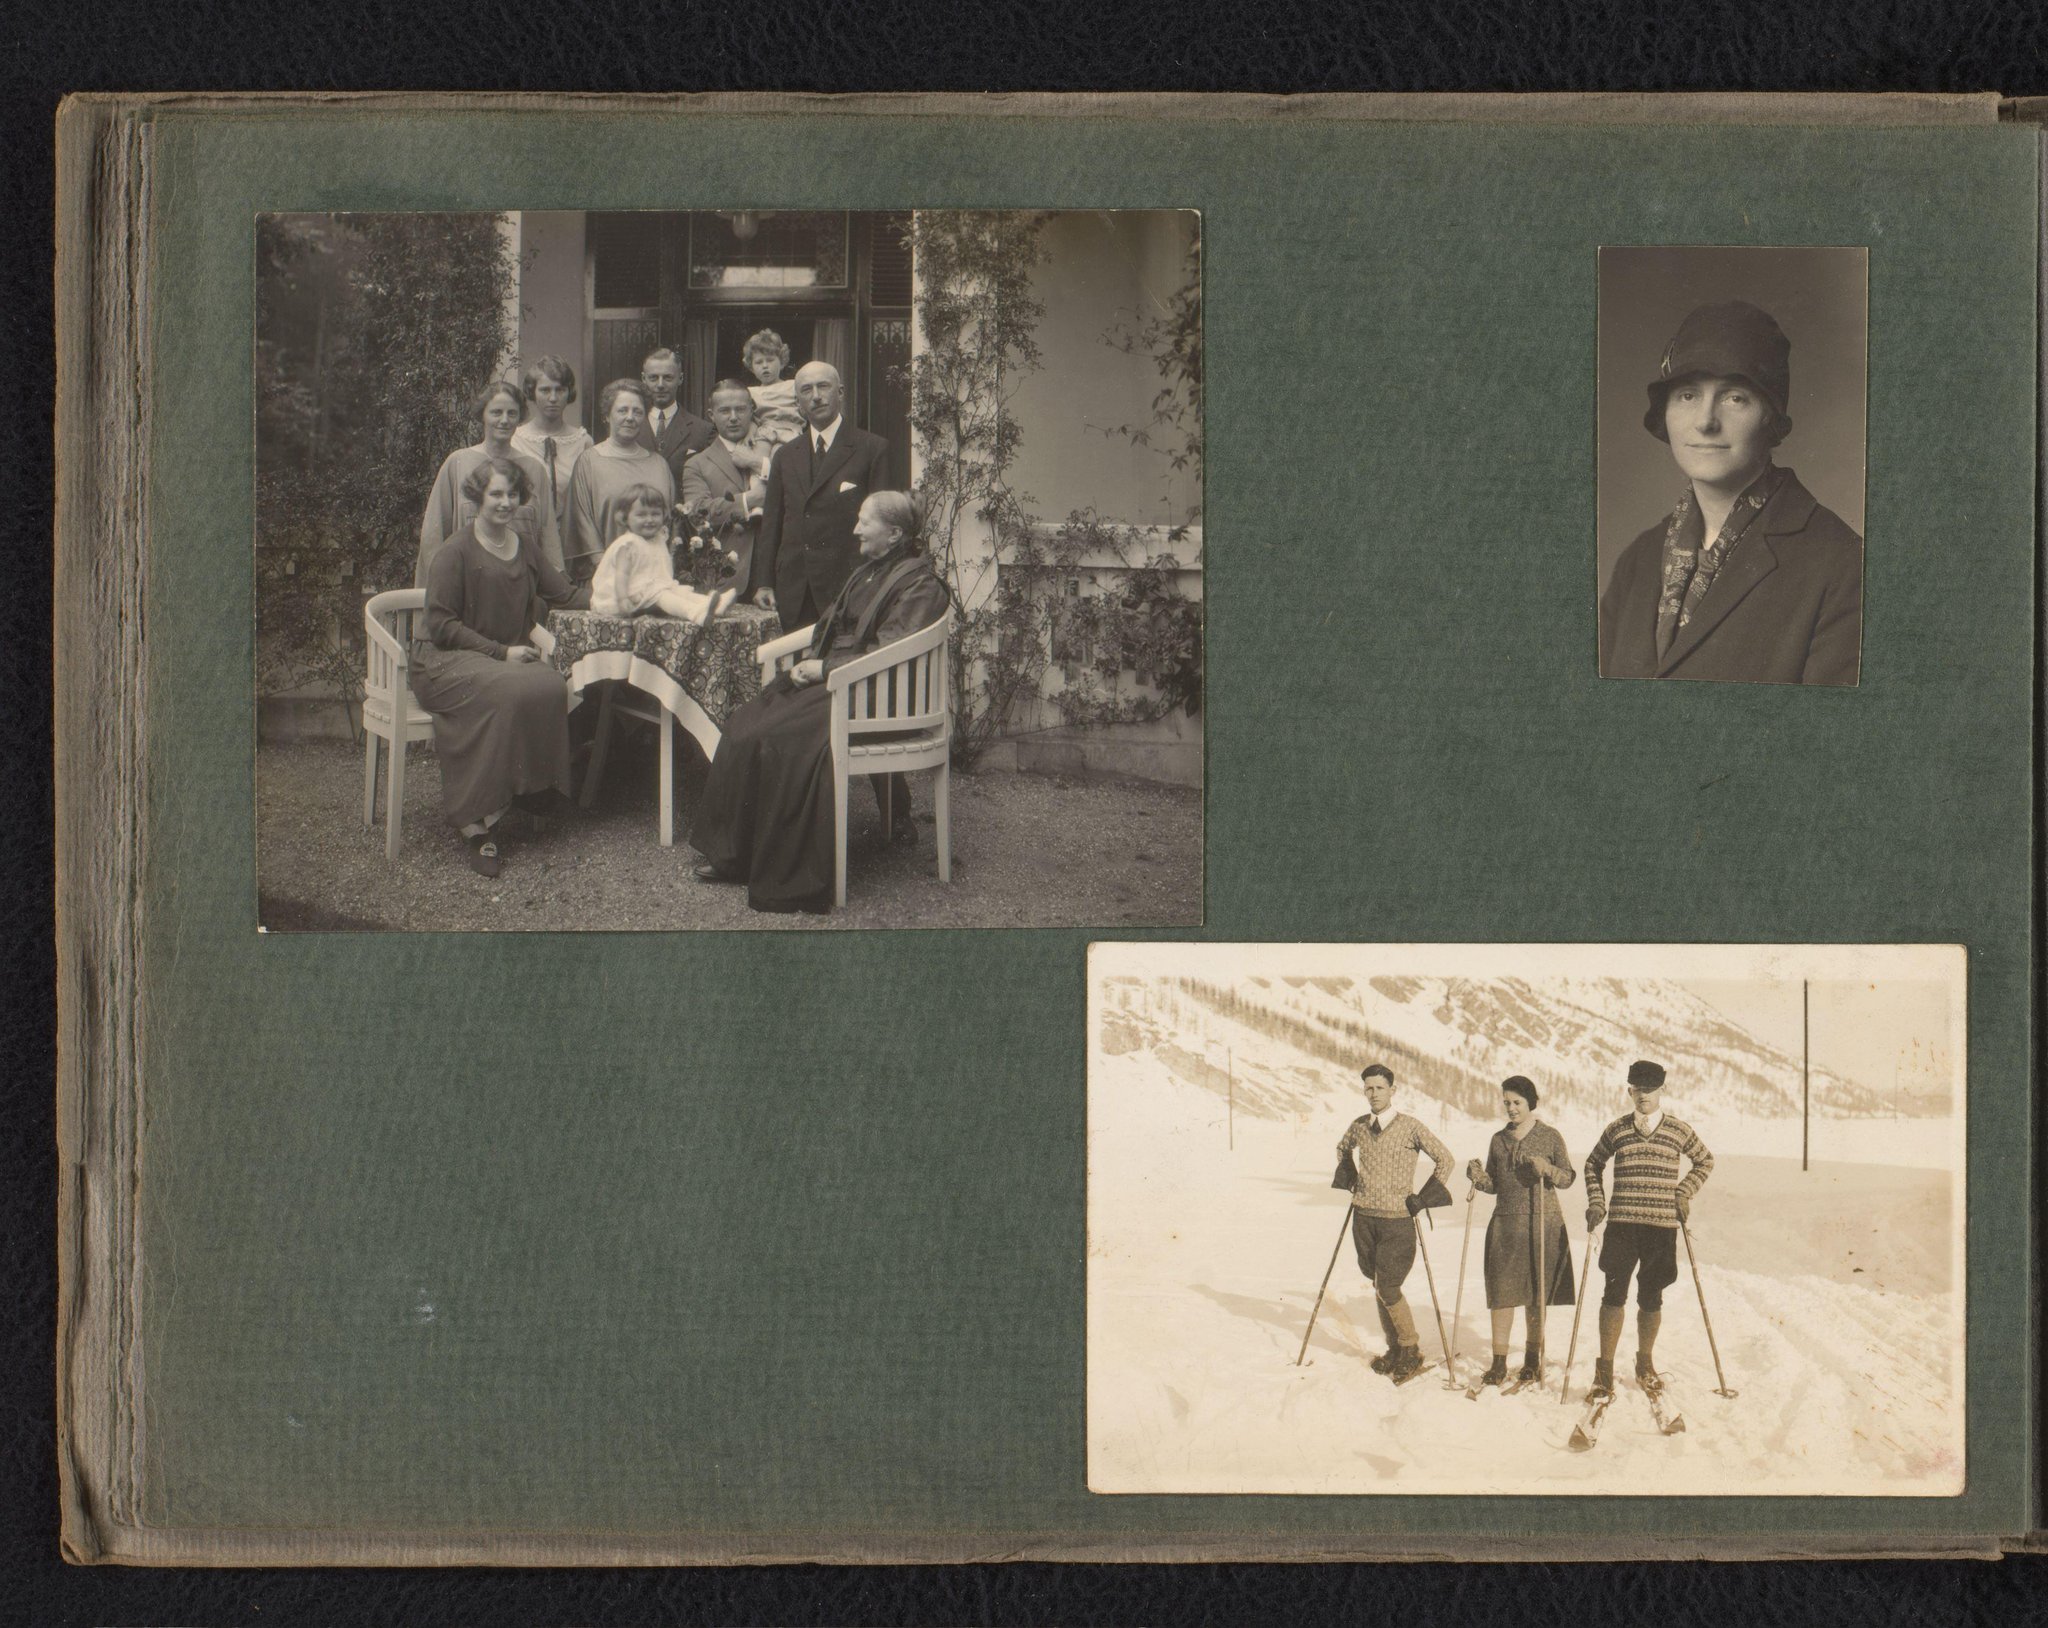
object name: photograph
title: Drie foto's met een familieportret, portret van een vrouw en drie mensen op ski's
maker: Anonymous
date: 1920-1930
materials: paper, cardboard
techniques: gelatin silver print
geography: europe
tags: skis (winter sports), historical persons - bb - woman, historical persons, family life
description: Deze foto's maken deel uit van een album.